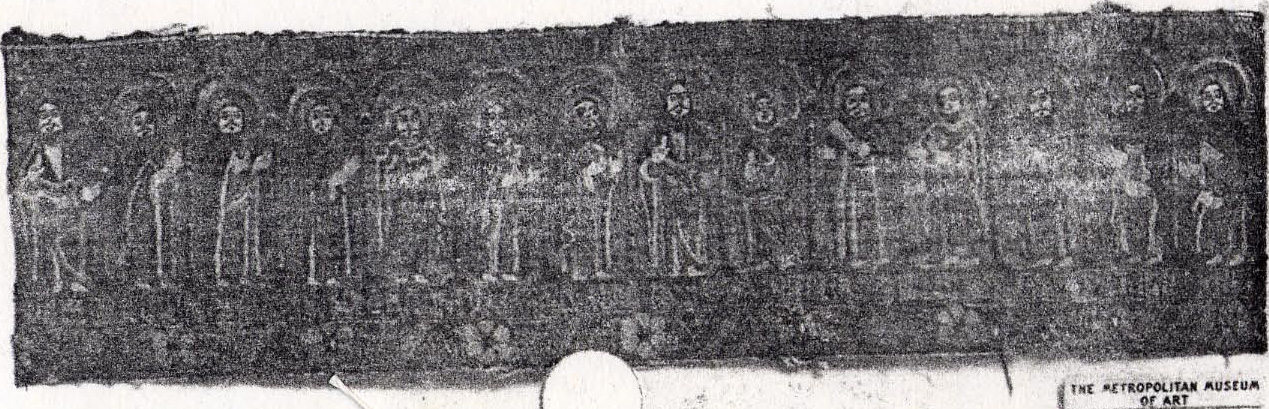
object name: panel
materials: gold, thread, wool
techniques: embroidery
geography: armenia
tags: human figures